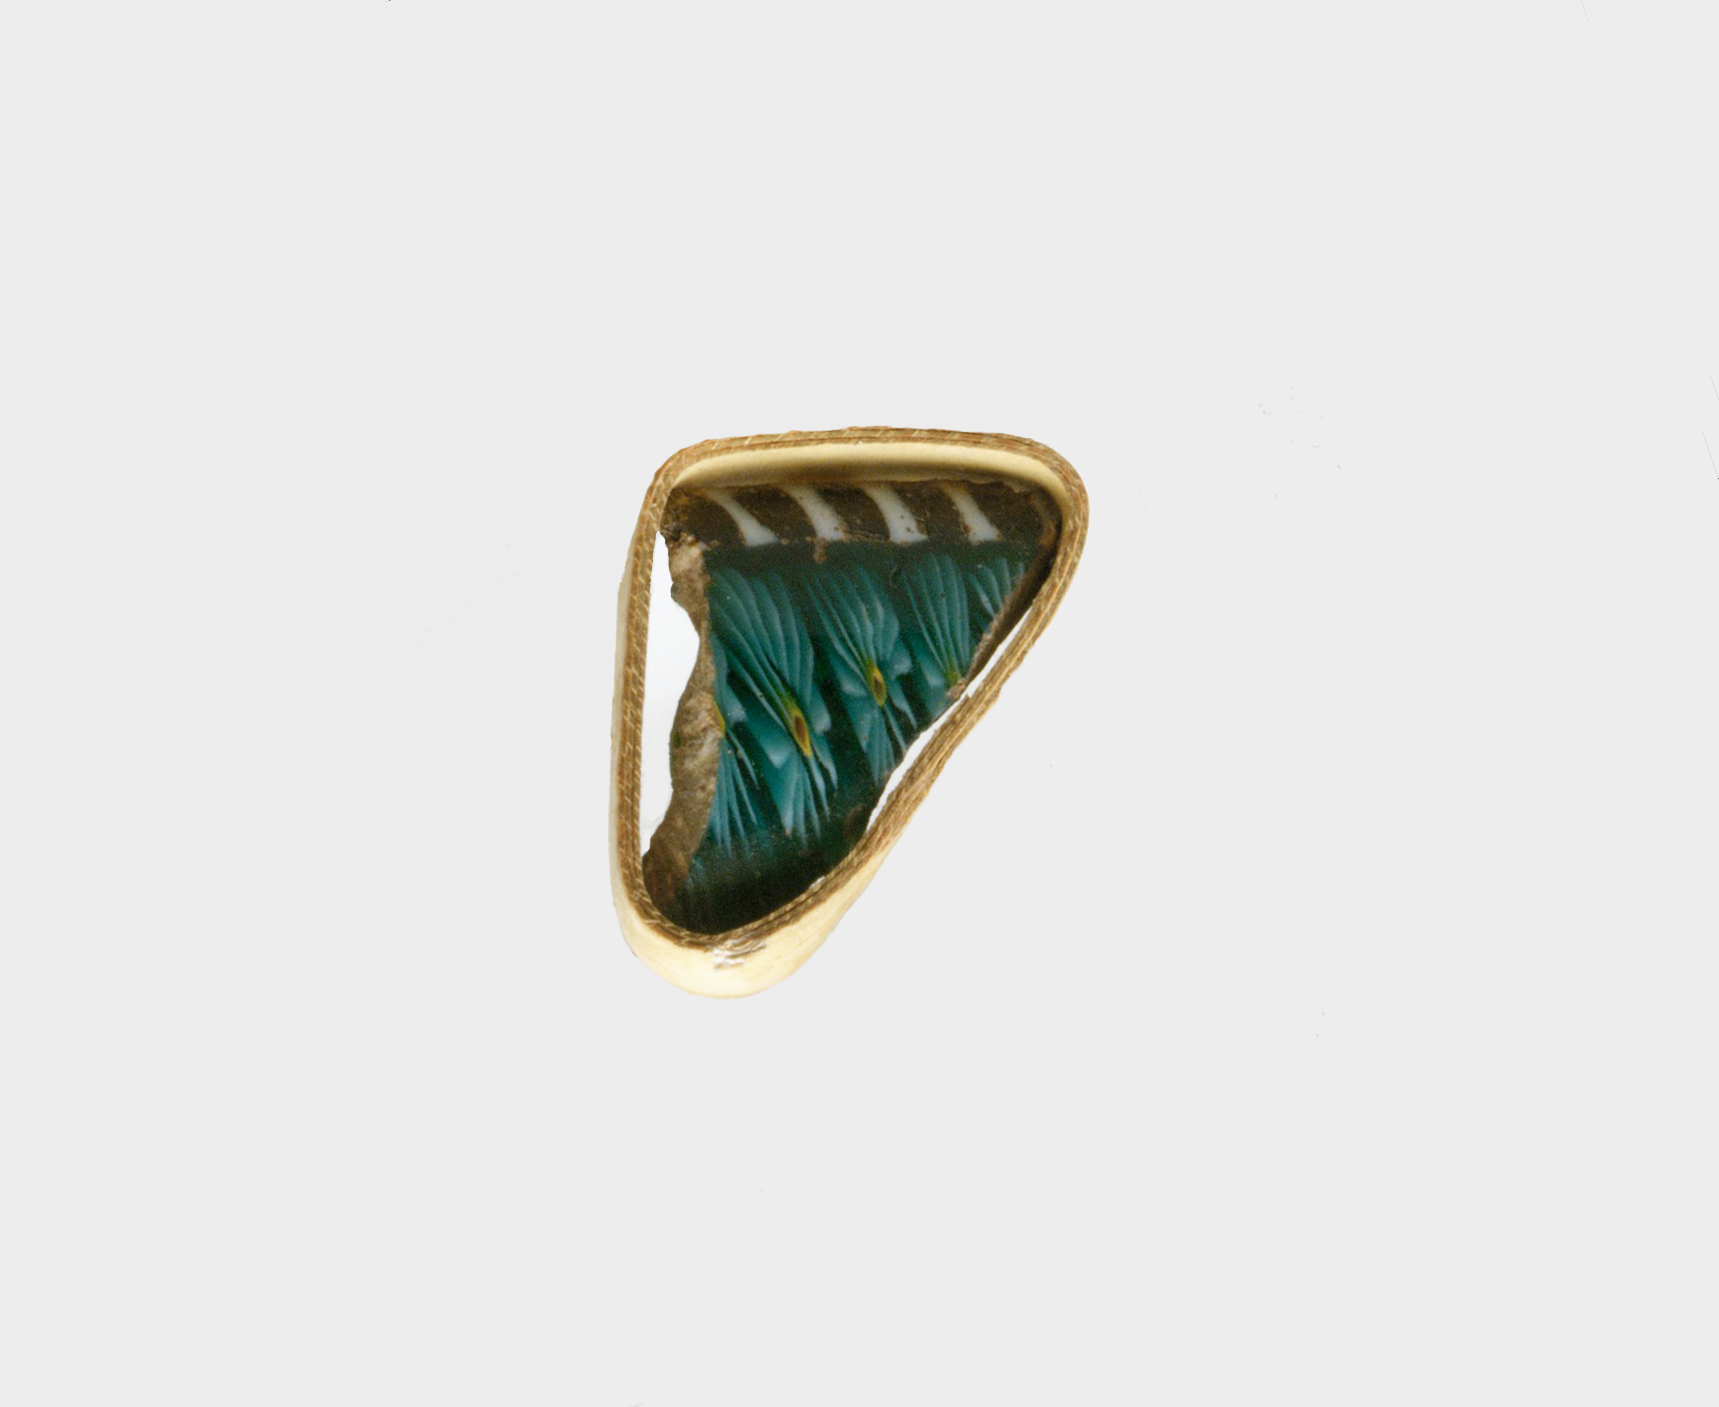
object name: fragment, mosaic dish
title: Glass mosaic dish fragment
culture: greek, eastern mediterranean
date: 200-101 BCE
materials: glass